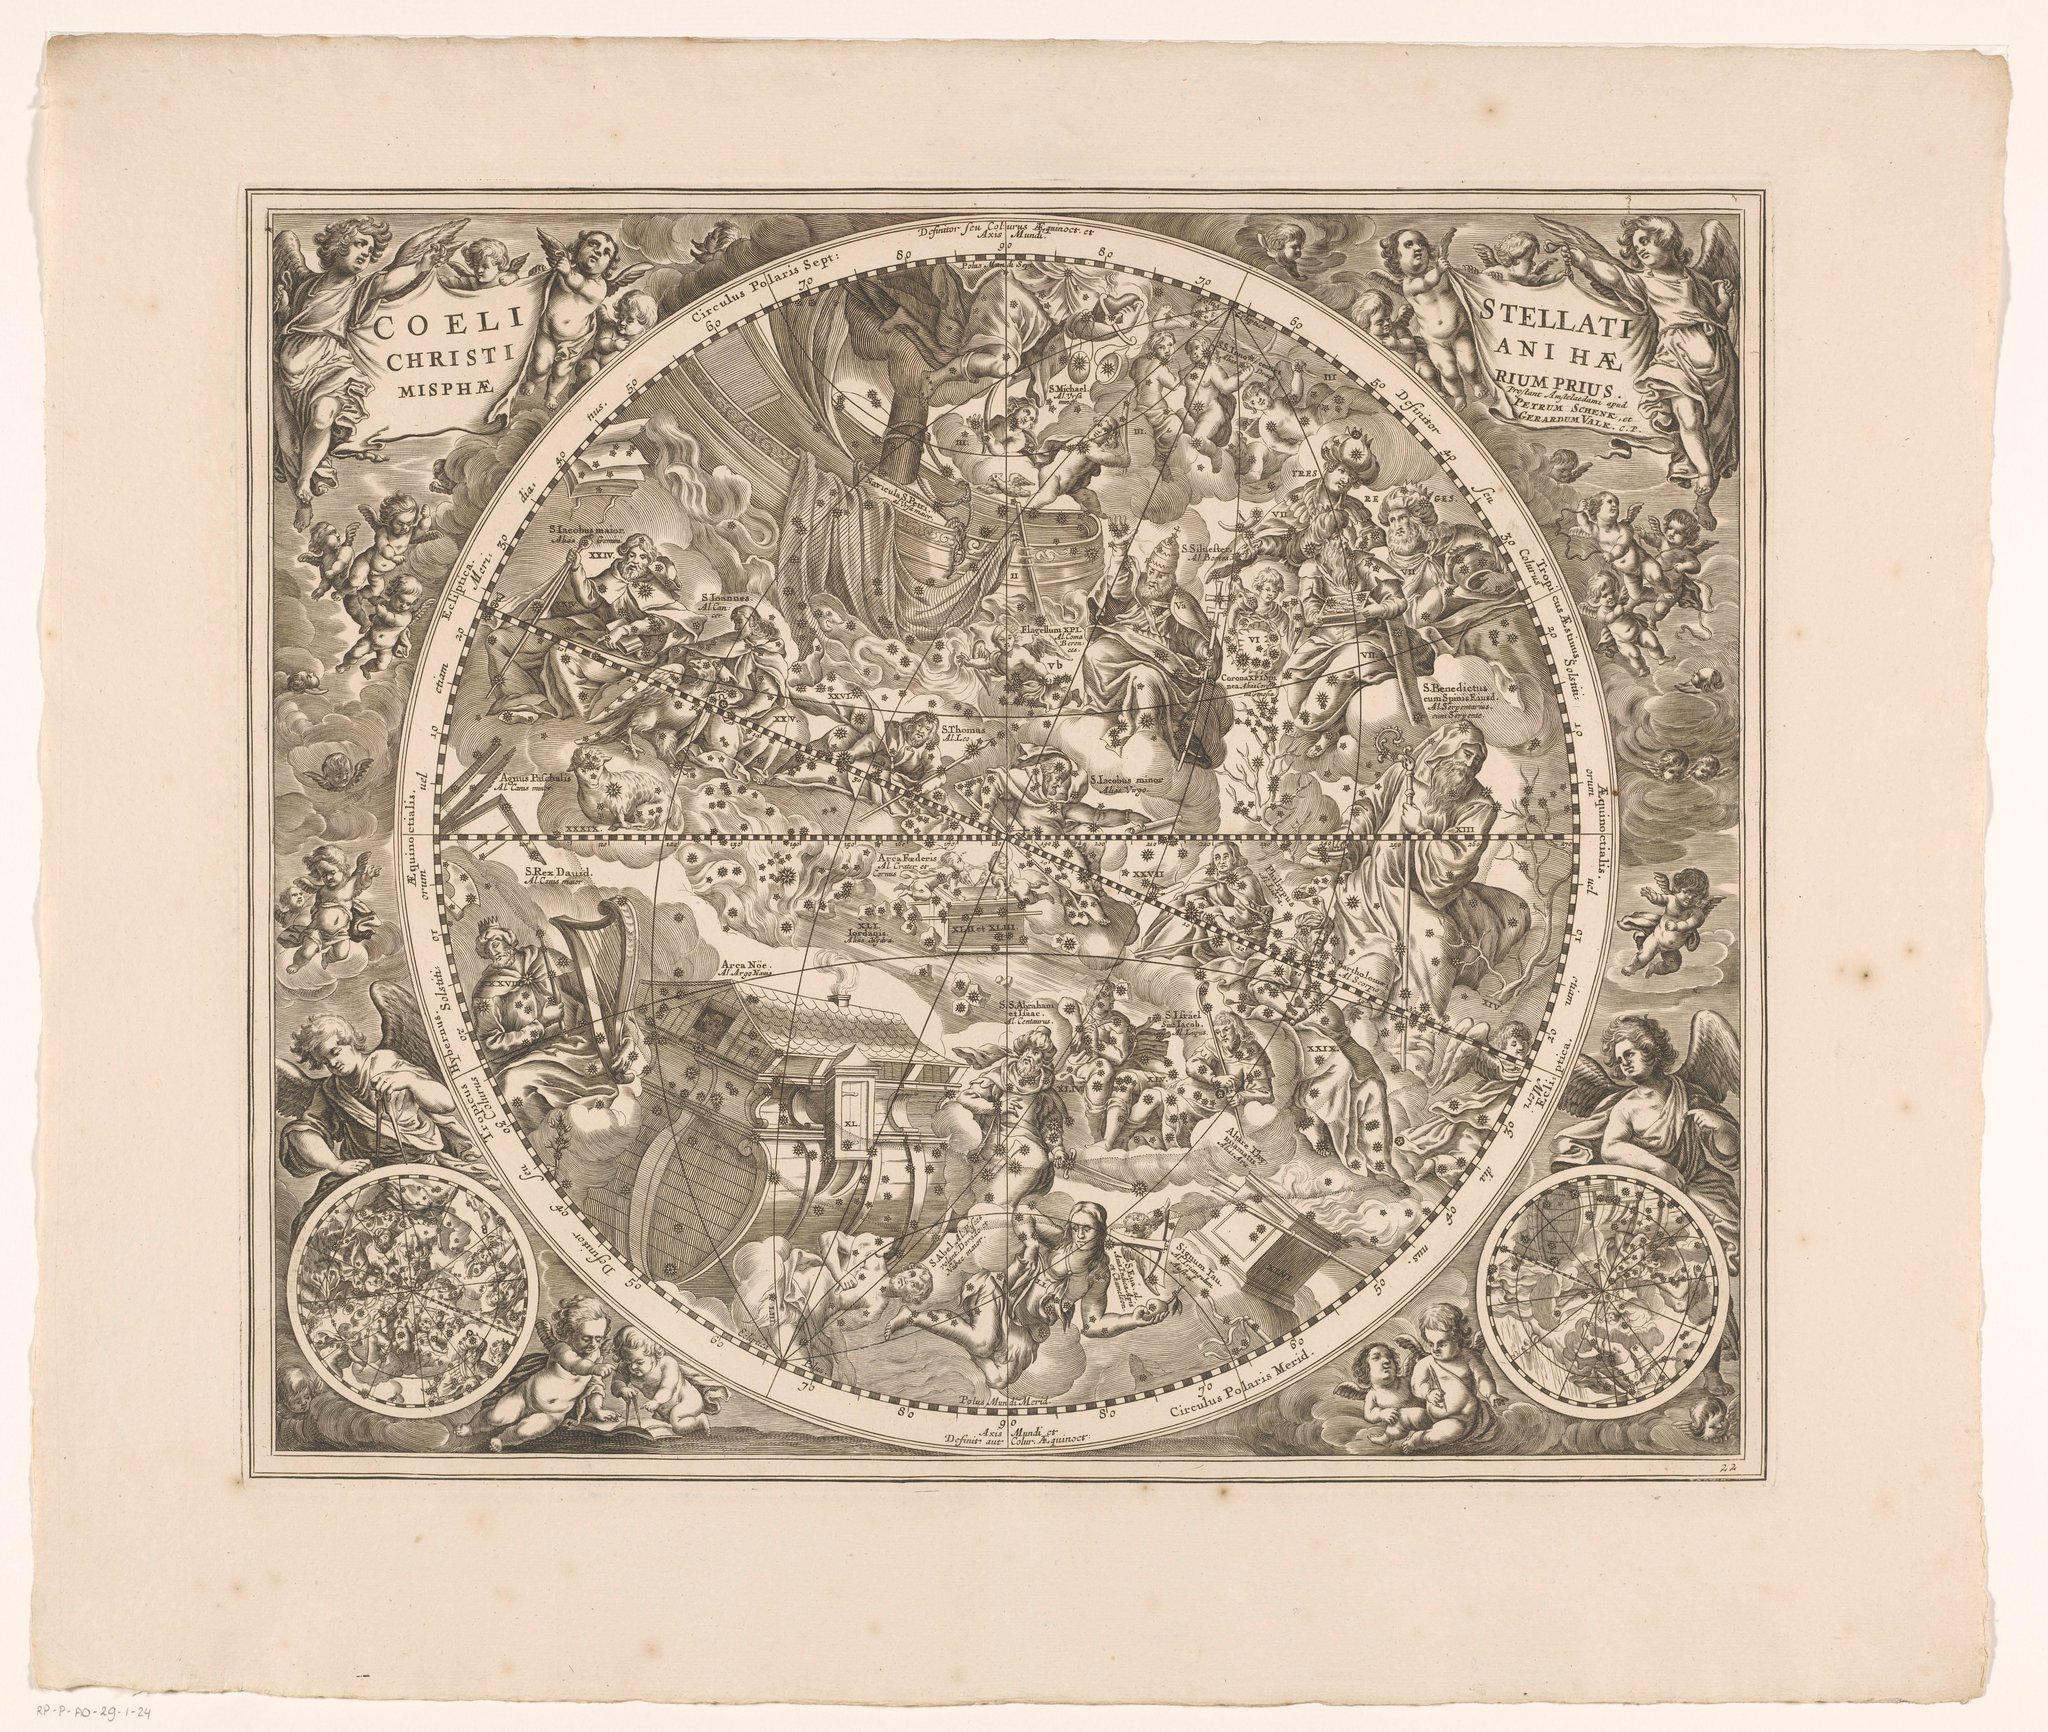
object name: print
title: Hemelkaart met Christelijke sterrenbeelden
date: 1660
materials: paper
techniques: engraving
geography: amsterdam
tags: zodiac; the twelve zodiacal signs together, star-chart, star map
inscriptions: collector's mark: Lugt 2228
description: Hemelkaart van de voorjaarshemelsfeer met de Christelijke sterrenbeelden, gebaseerd op de atlas van Julius Schiller uit 1627. In plaats van de gebruikelijke sterrenbeelden in de dierenriem zijn apostelen te zien. Links- en rechtsonder twee bollen waarin delen van de kaart van dichterbij te zien zijn. Links- en rechtsboven de titelcartouches, gedragen door putti. Rechtsonder genummerd: 22.